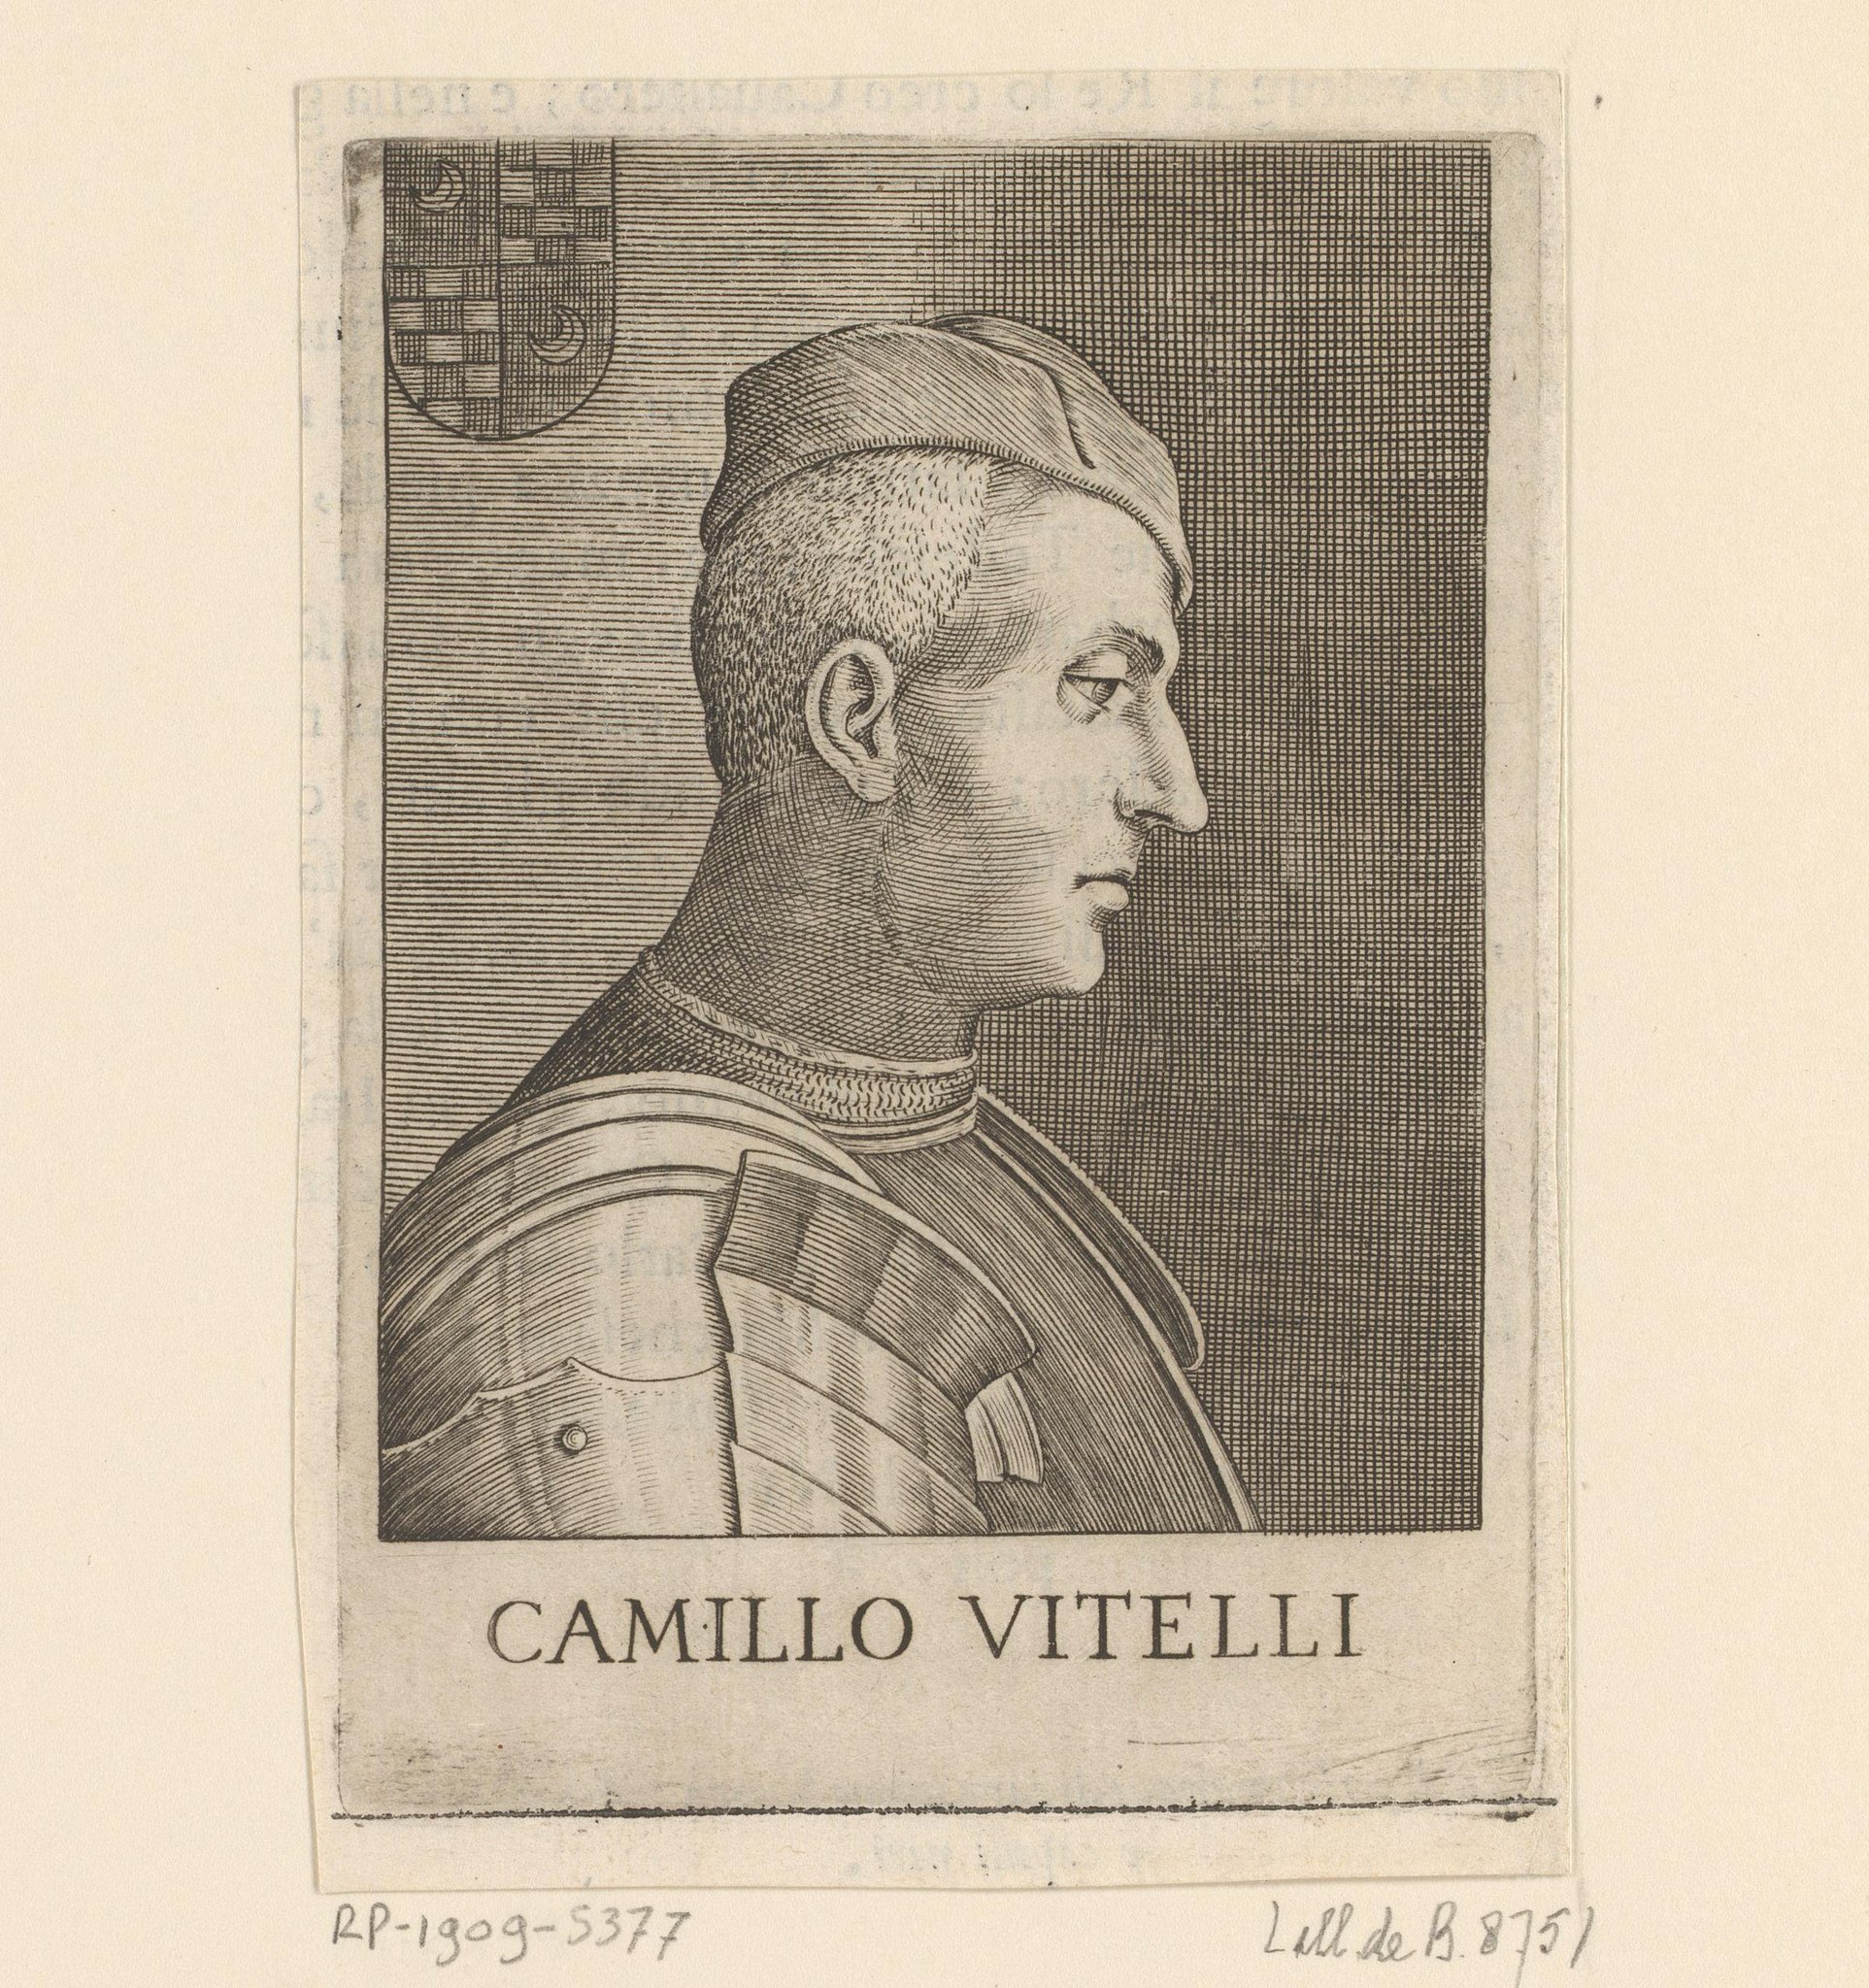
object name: print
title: Portret van legeraanvoerder Camillo Vitelli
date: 1646-1647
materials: paper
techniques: engraving, letterpress printing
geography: rome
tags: commander-in-chief, general, marshal, historical persons, armorial bearing, heraldry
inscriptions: collector's mark: Lugt 2228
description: Prent uit: Ritratti et elogii di capitani Illustri. Che ne'secoli moderni hanno gloriosamente guerreggiato. Rome: Filippo de'Rossi en Vitale Mascardi, 1646, p. 177. Prent ook gebruikt in dezelfde editie van 1647. Eerdere staten van prent in ieder geval gebruikt in: Ritratti et elogii di capitani Illustri. Rome: Pompilio Totti en Andrea Fei, 1635. En in: Ritratti di cento capitani illustri con li lor Fatti in guerra (…), Rome: Domenico Gigliotti, 1596.